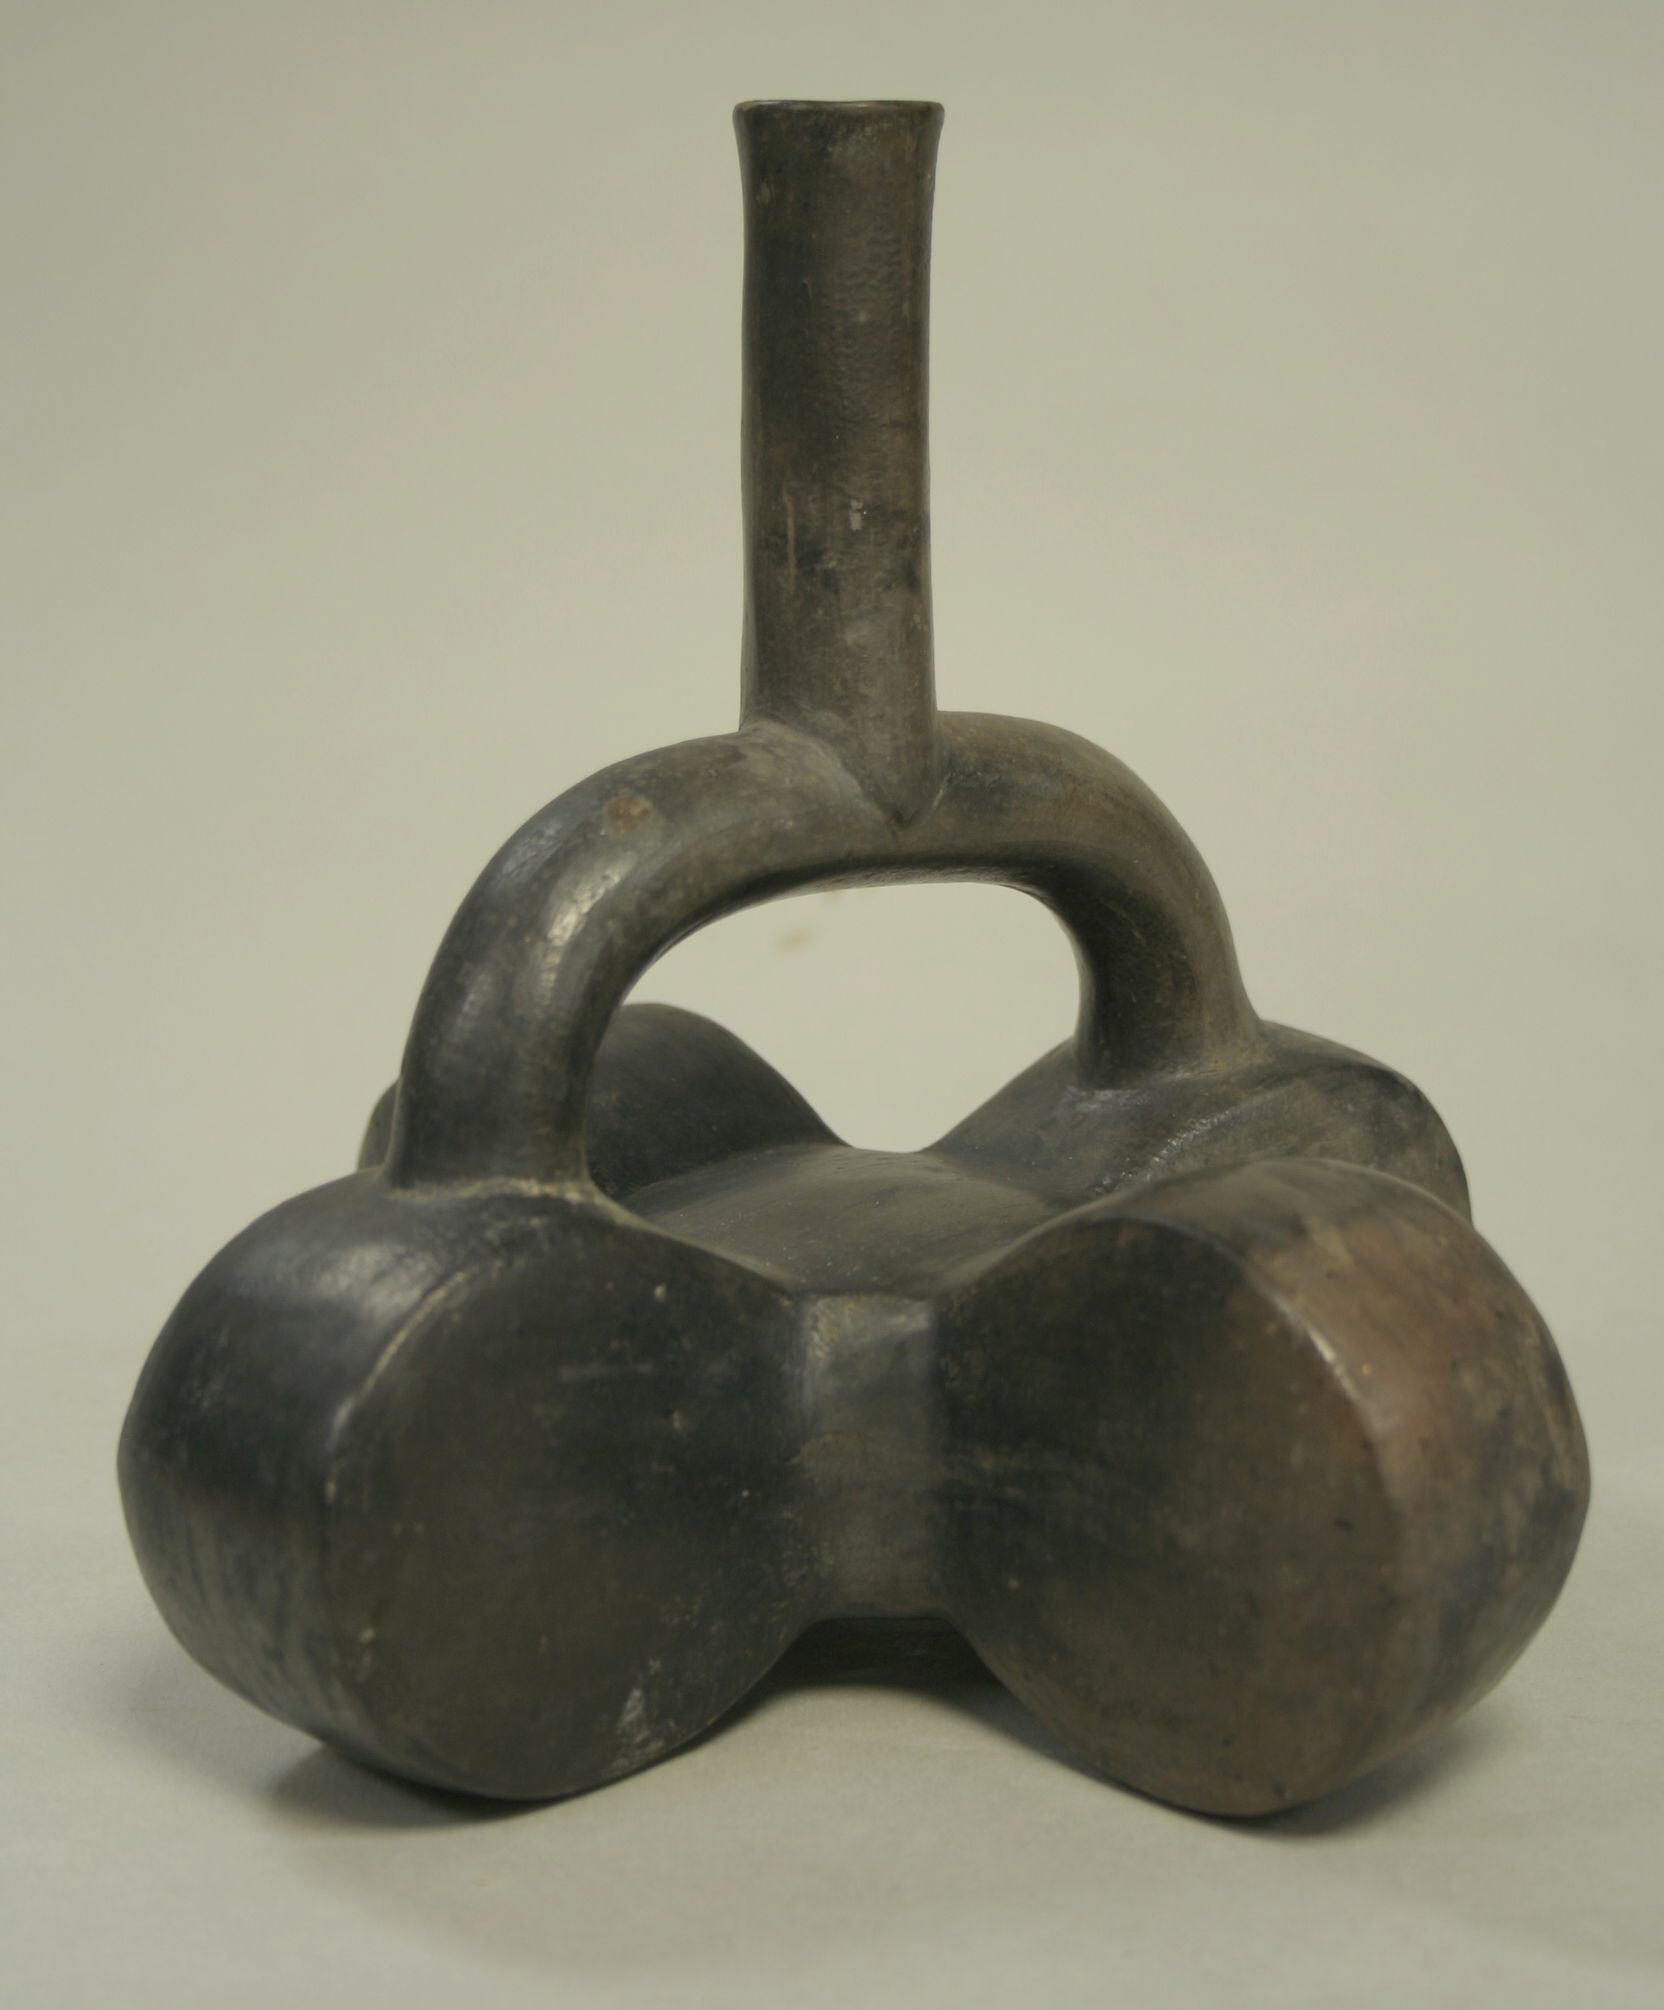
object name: bottle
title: Compartmented Stirrup Spout Jar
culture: chimú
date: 1101-1500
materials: ceramic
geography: peru